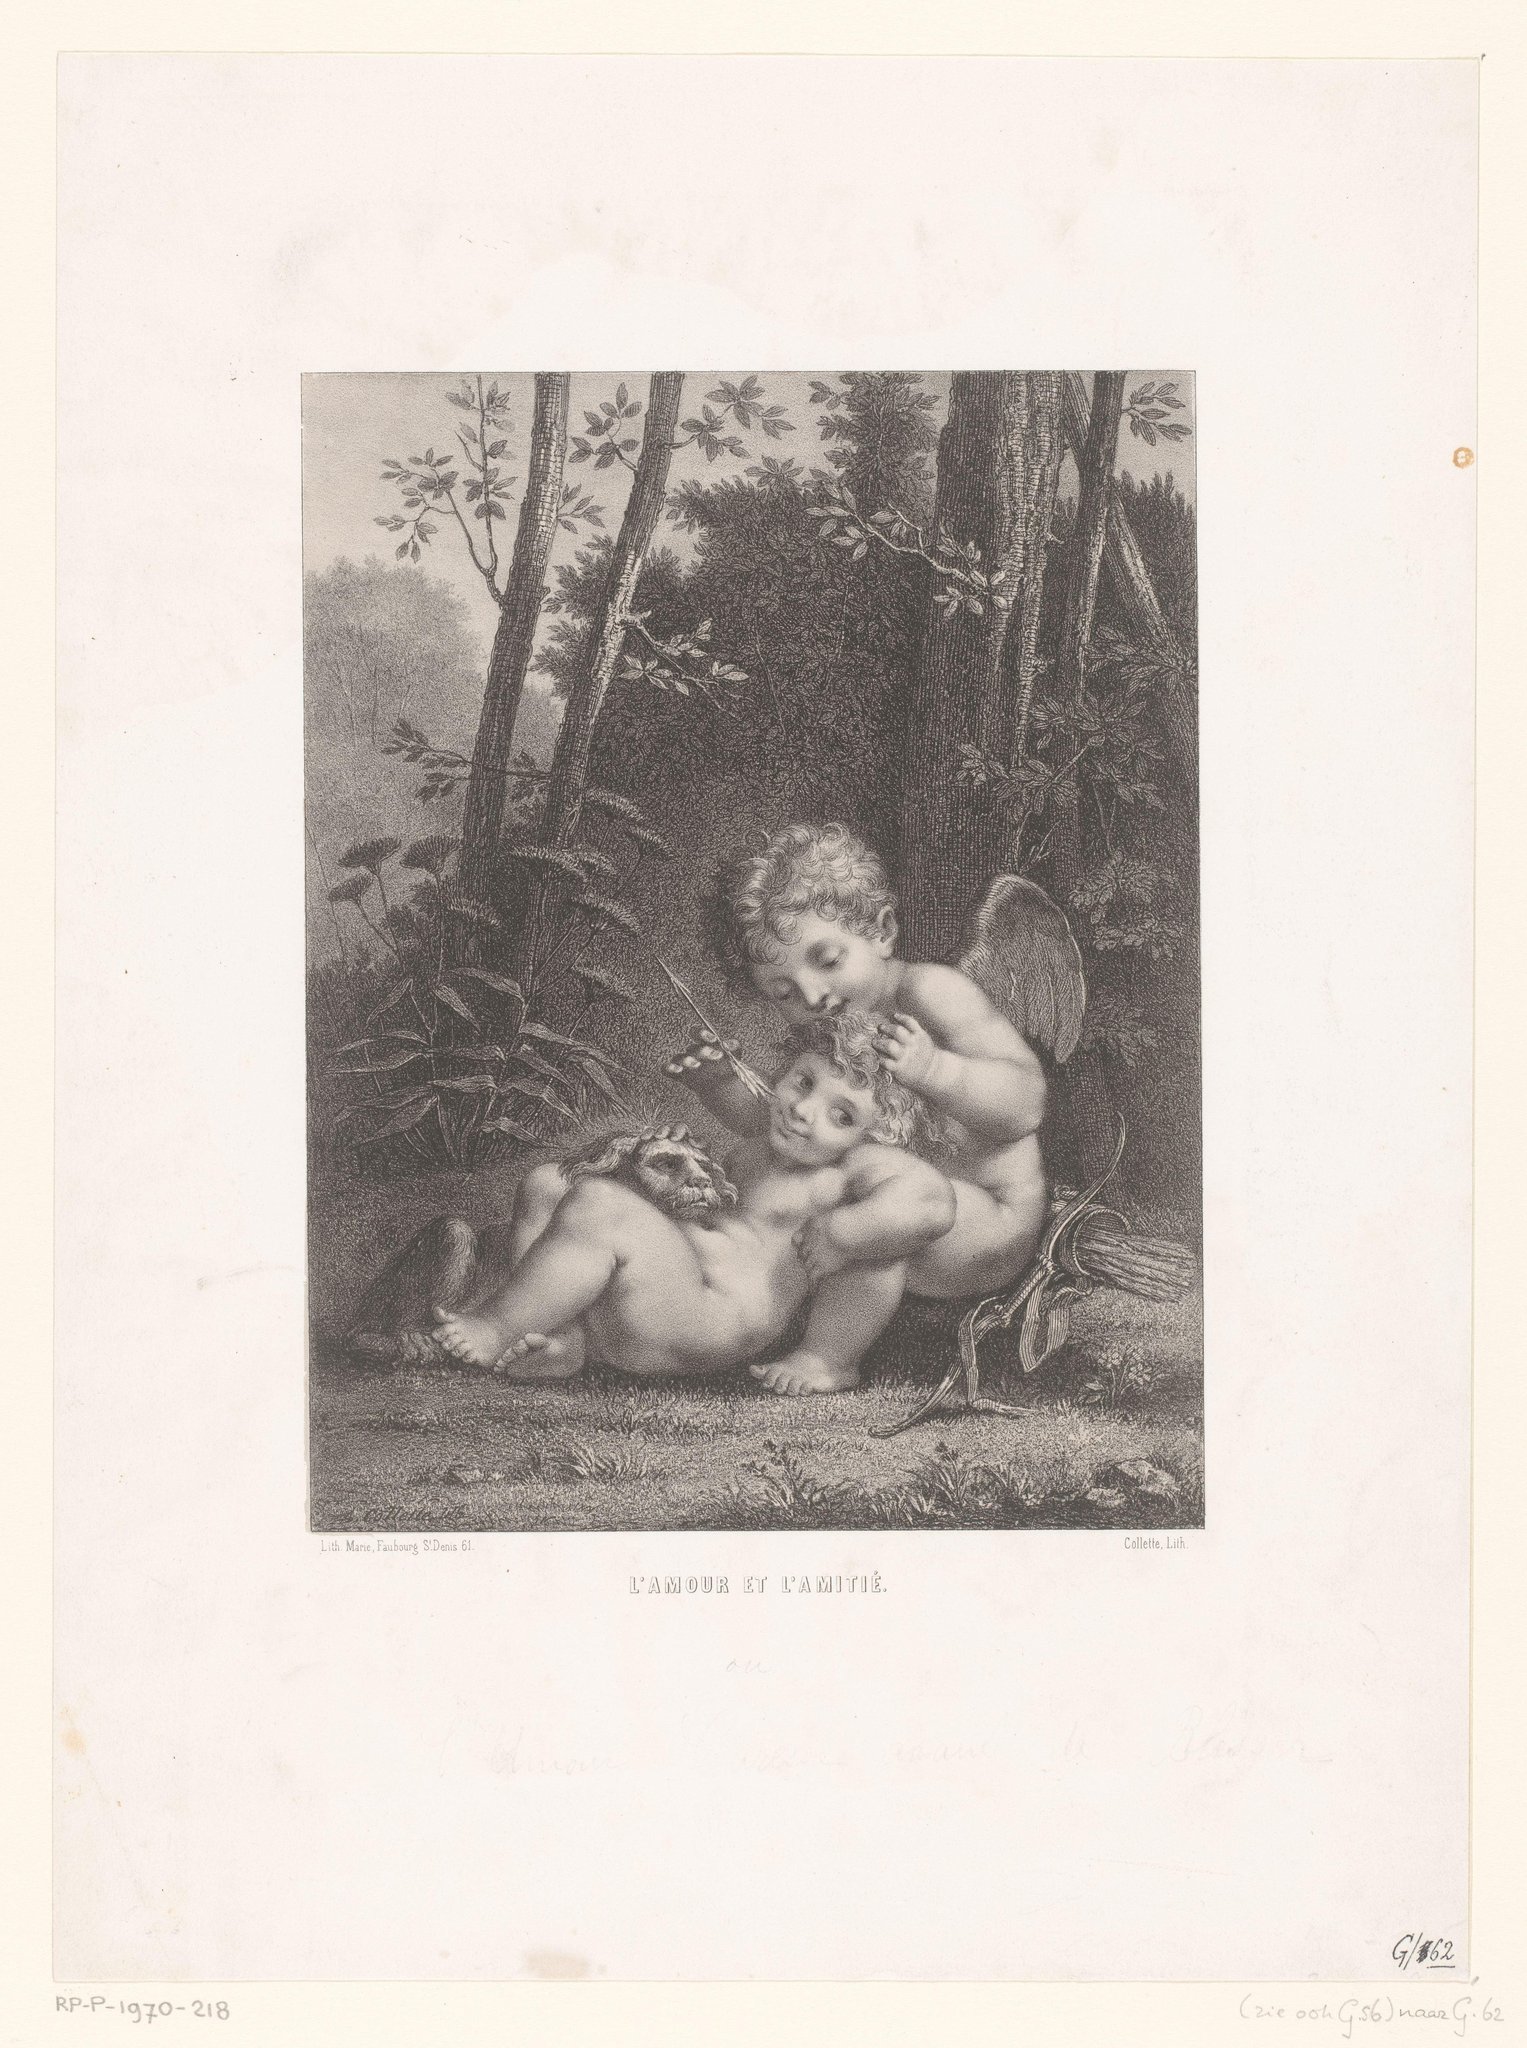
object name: print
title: Liefde en Vriendschap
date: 1824-1876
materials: paper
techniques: lithograph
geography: paris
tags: friendship; 'amicitia' (ripa), (story of) cupid, amor (eros)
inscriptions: collector's mark: Lugt 2760, collector's mark: Lugt 2228